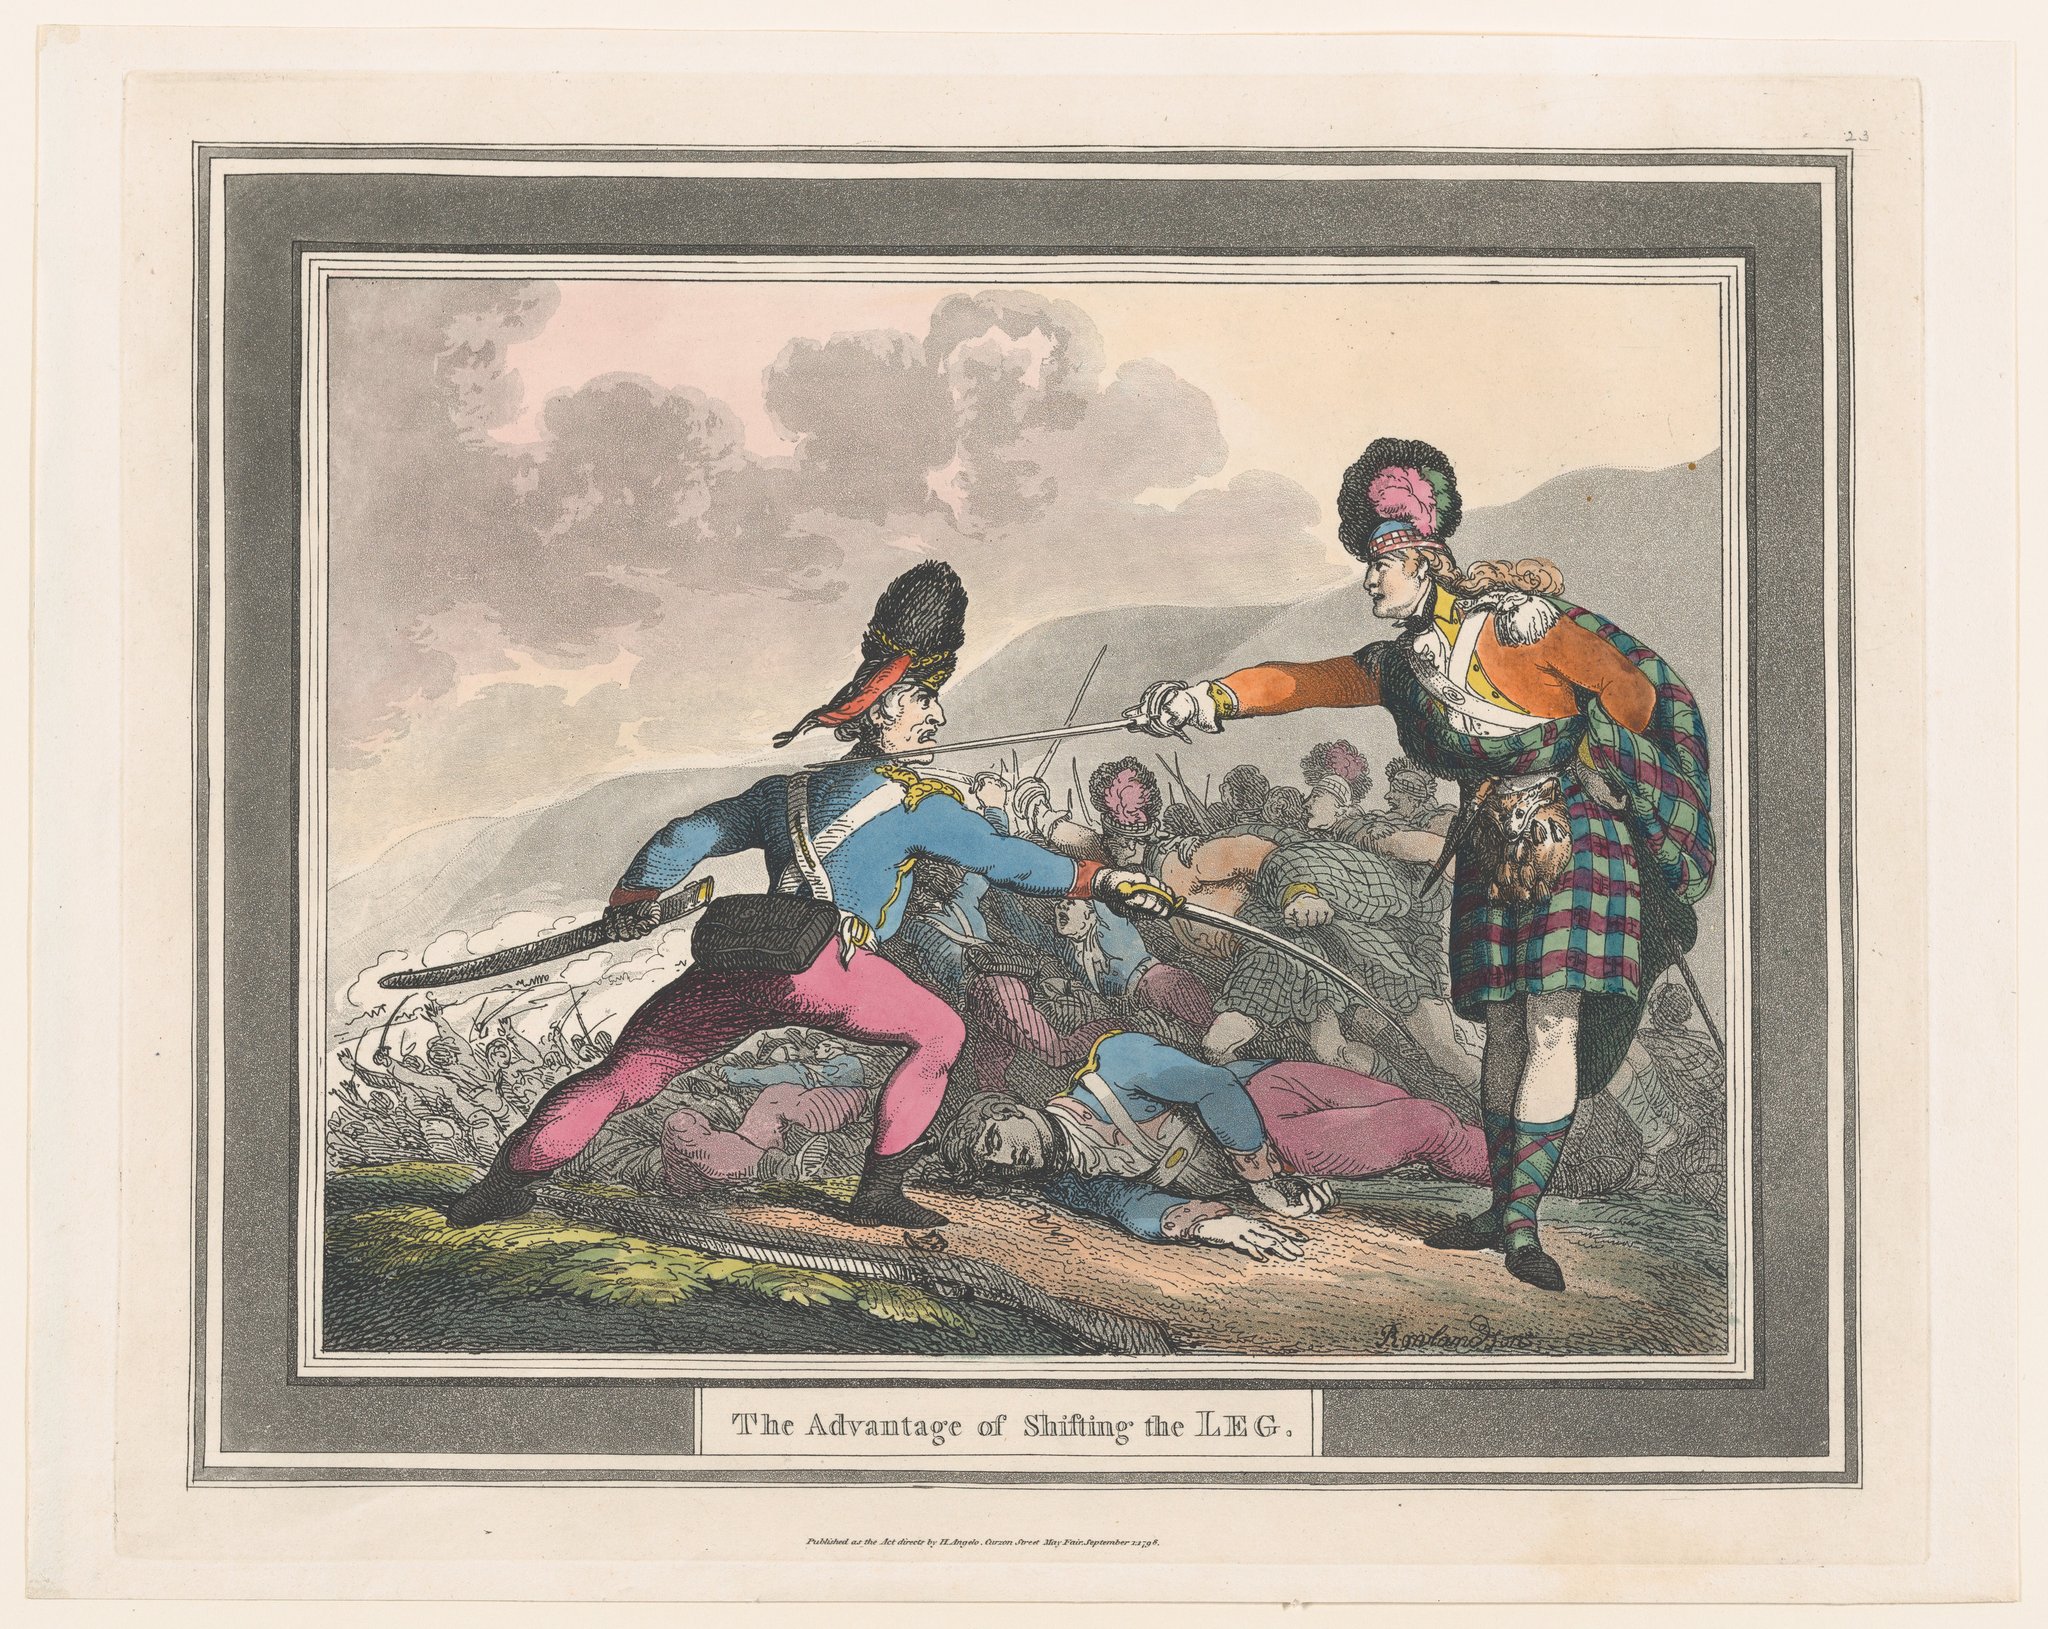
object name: print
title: The Advantage of Shifting the Leg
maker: thomas rowlandson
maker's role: artist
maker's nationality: british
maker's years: 1757-1827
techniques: aquatint, etching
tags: battles,soldiers,swords,death